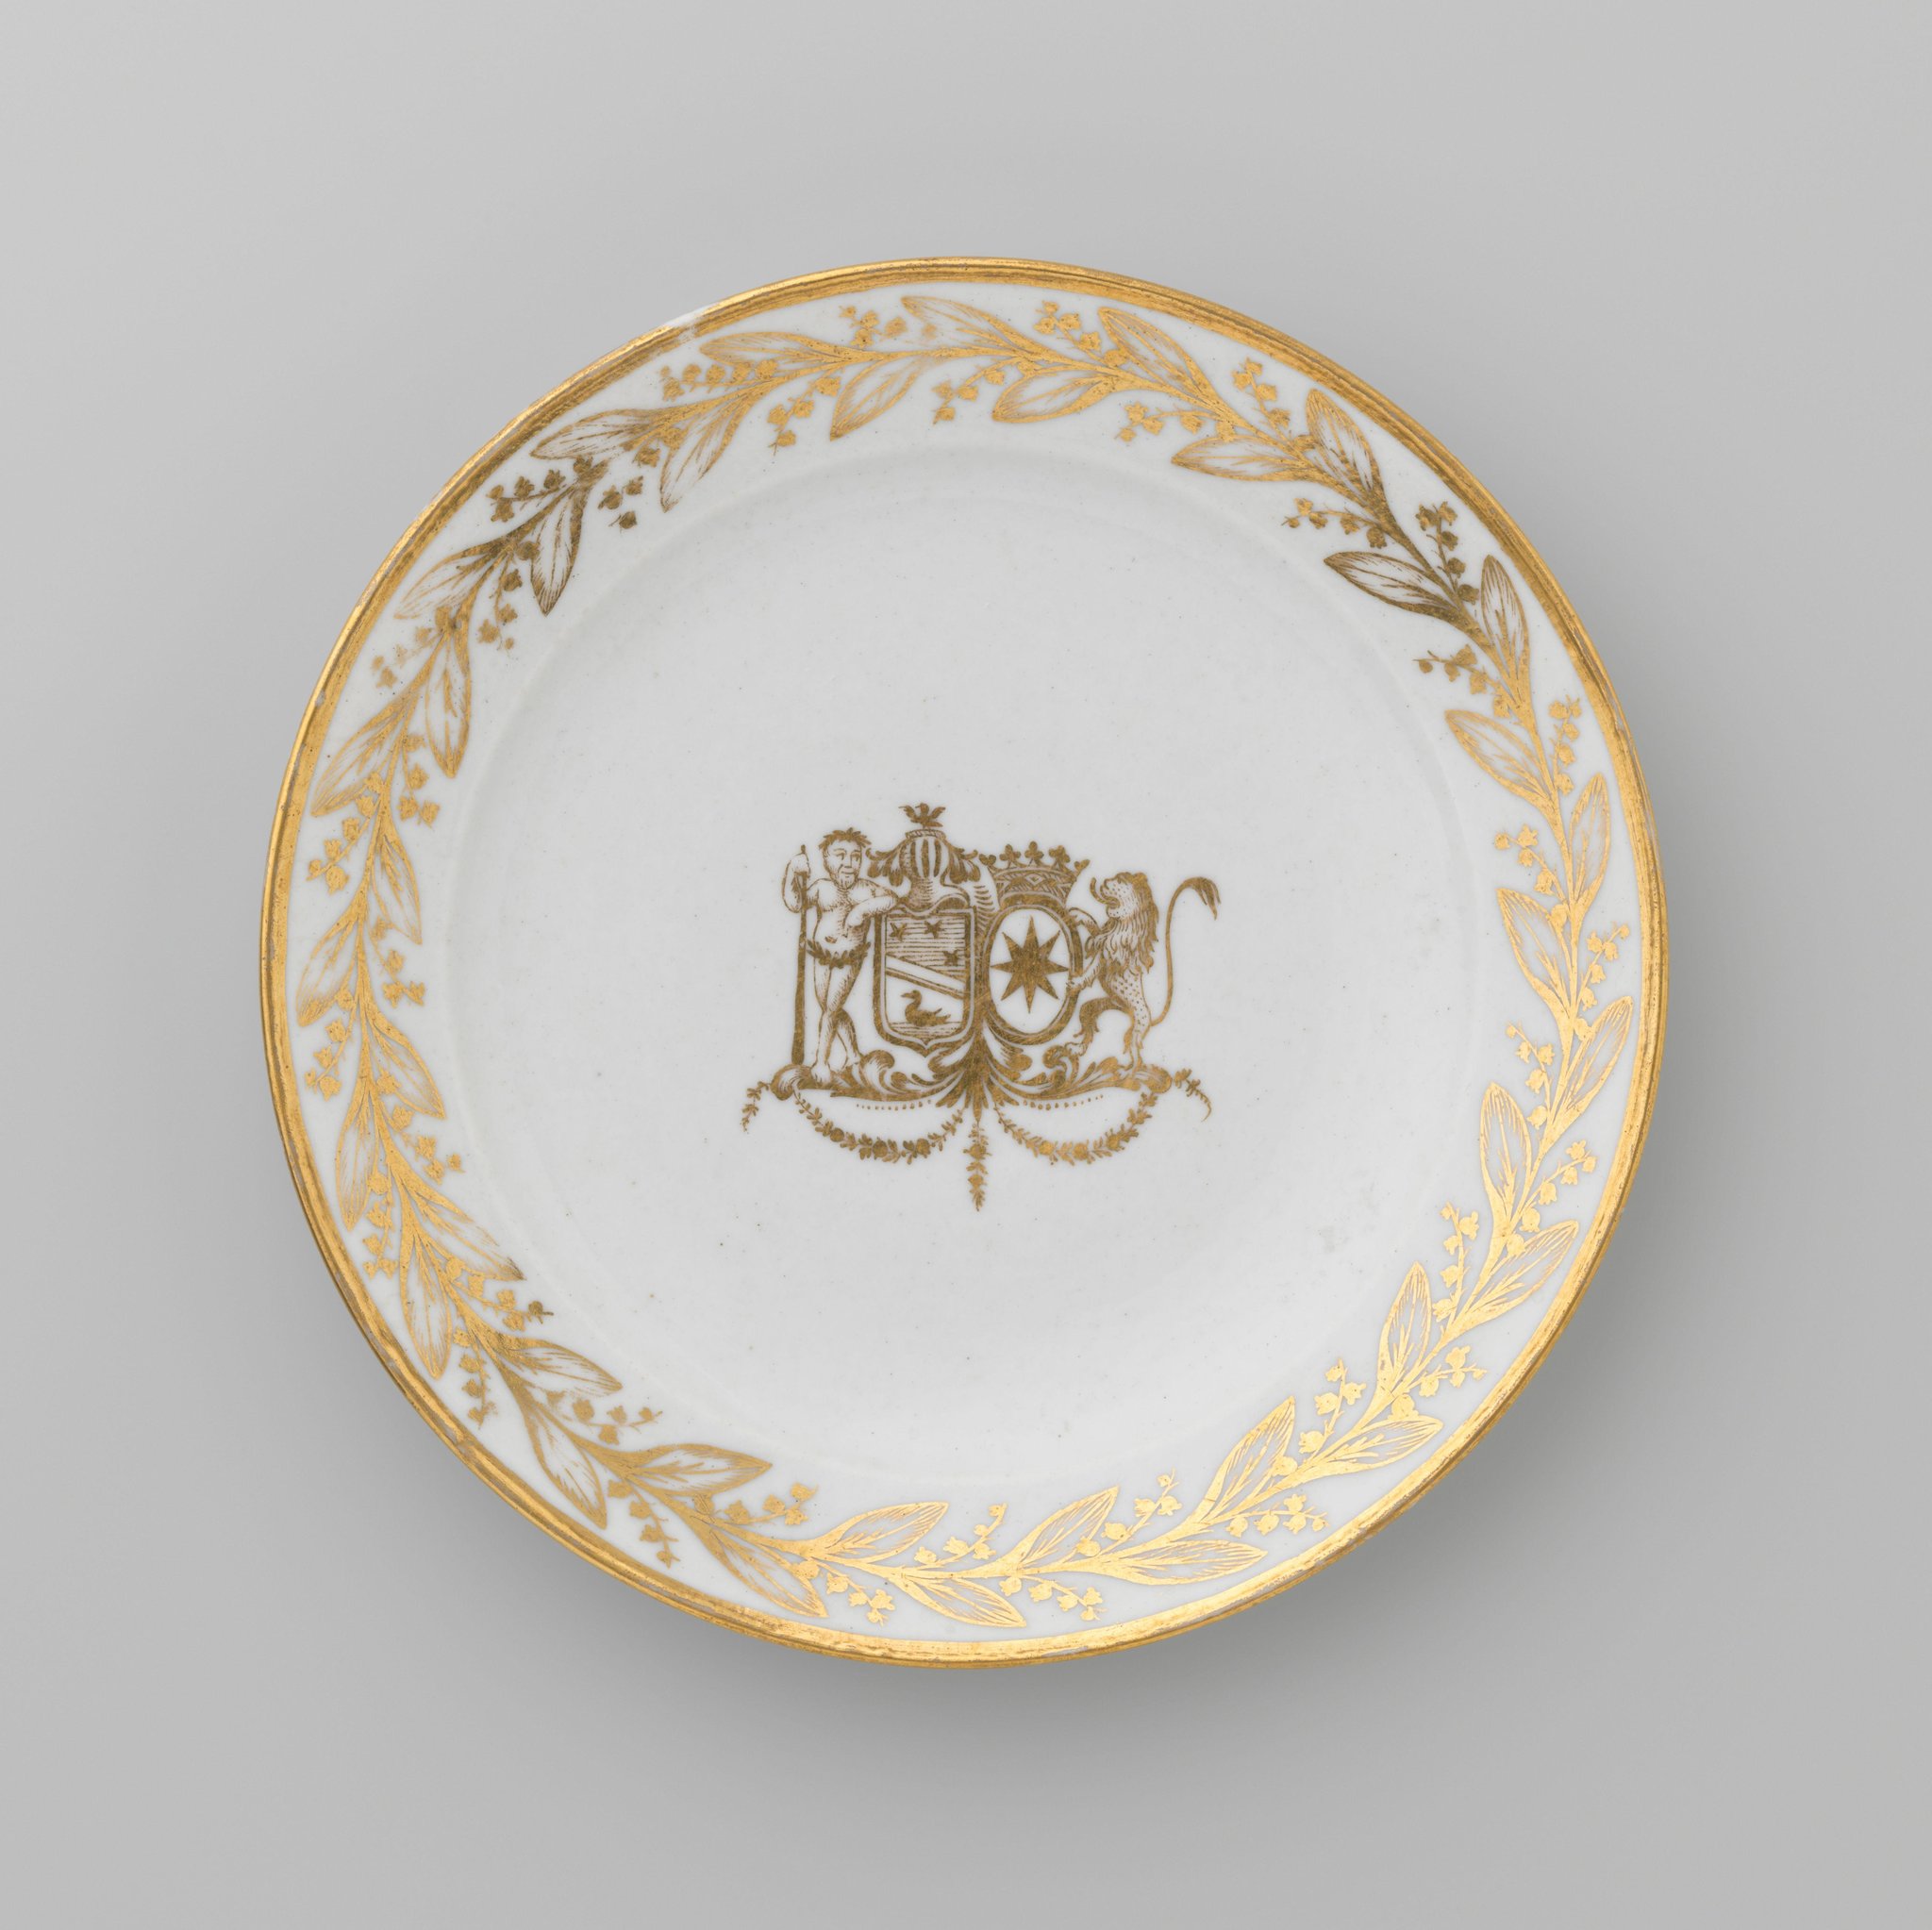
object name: plate dish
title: Plate with the coat of arms of Hendrik Peter Godfried Quack and Isabella Gertraud von Carnap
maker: Anonymous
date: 1790-1800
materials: glaze, gold, paint, porcelain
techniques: firing, forming, gilding, turning, vitrification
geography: paris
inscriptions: mark: ‘J?’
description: Bord van porselein, beschilderd op het glazuur met goud. Op het plat het alliantiewapen van Hendrik Peter Godfried Quack en Isabella Gertraud von Carnap. De rand met een bloemrank en een gouden band. Een proen op de onderzijde; porselein grijs van tint. Gemerkt op de onderzijde met J[?].